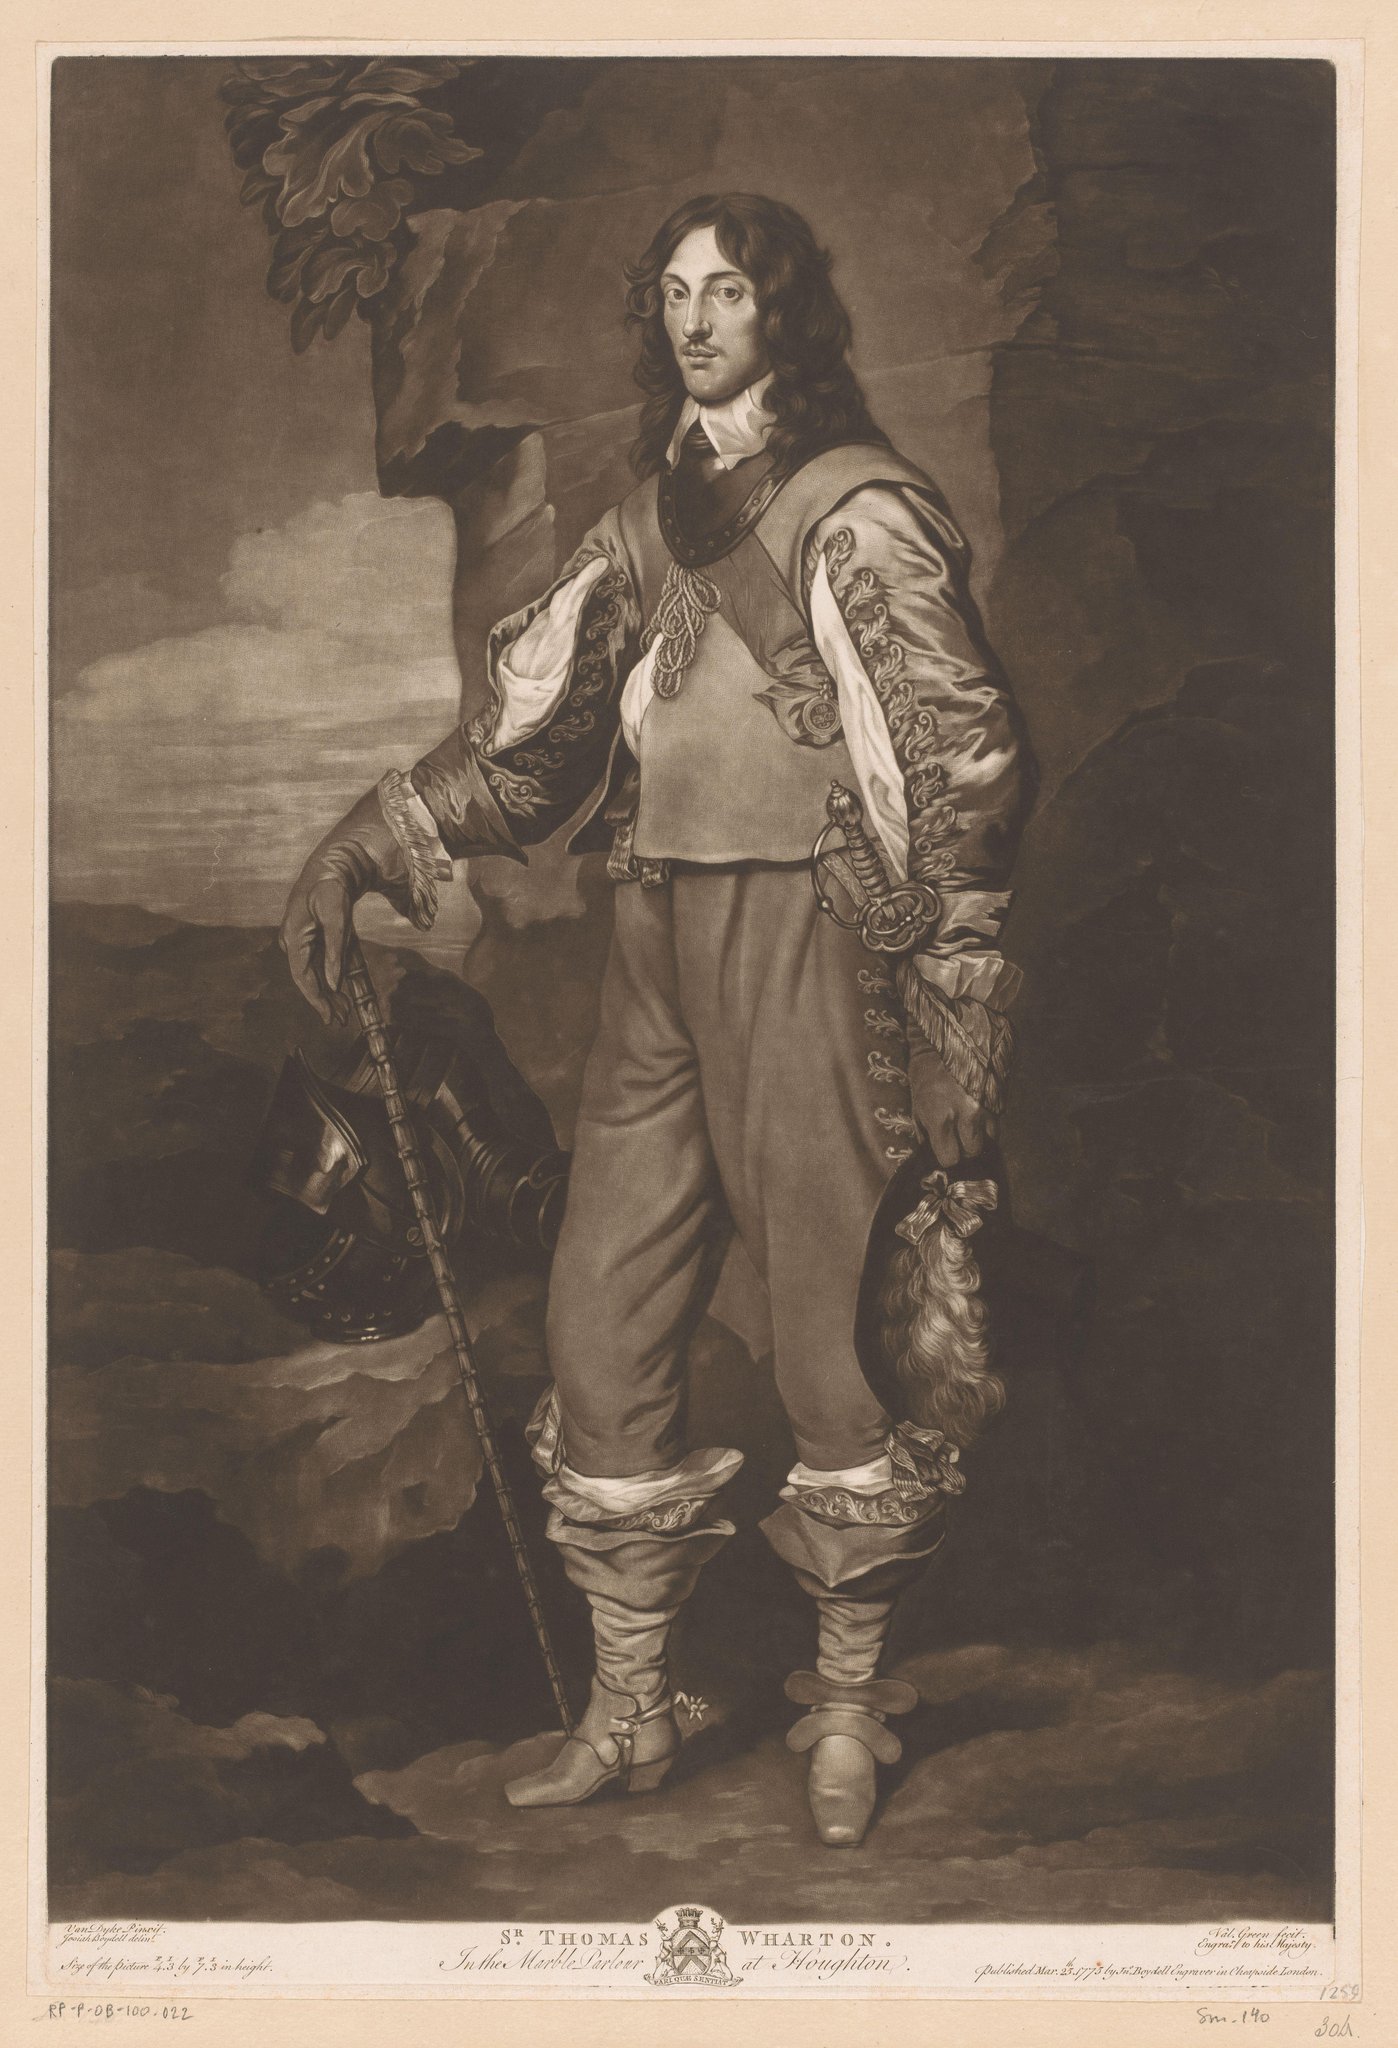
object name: print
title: Portret van Thomas Wharton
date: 1775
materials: paper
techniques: etching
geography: london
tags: historical persons, politician, e.g. party leader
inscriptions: collector's mark: Lugt 240